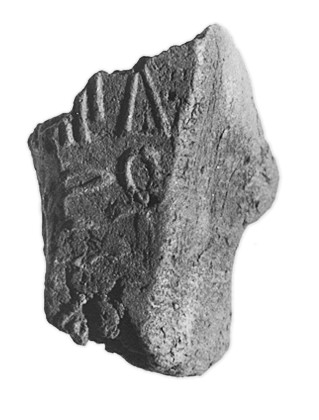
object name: sealing, administrative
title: Administrative Seal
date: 1981-1640 BCE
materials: clay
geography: egypt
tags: ankh